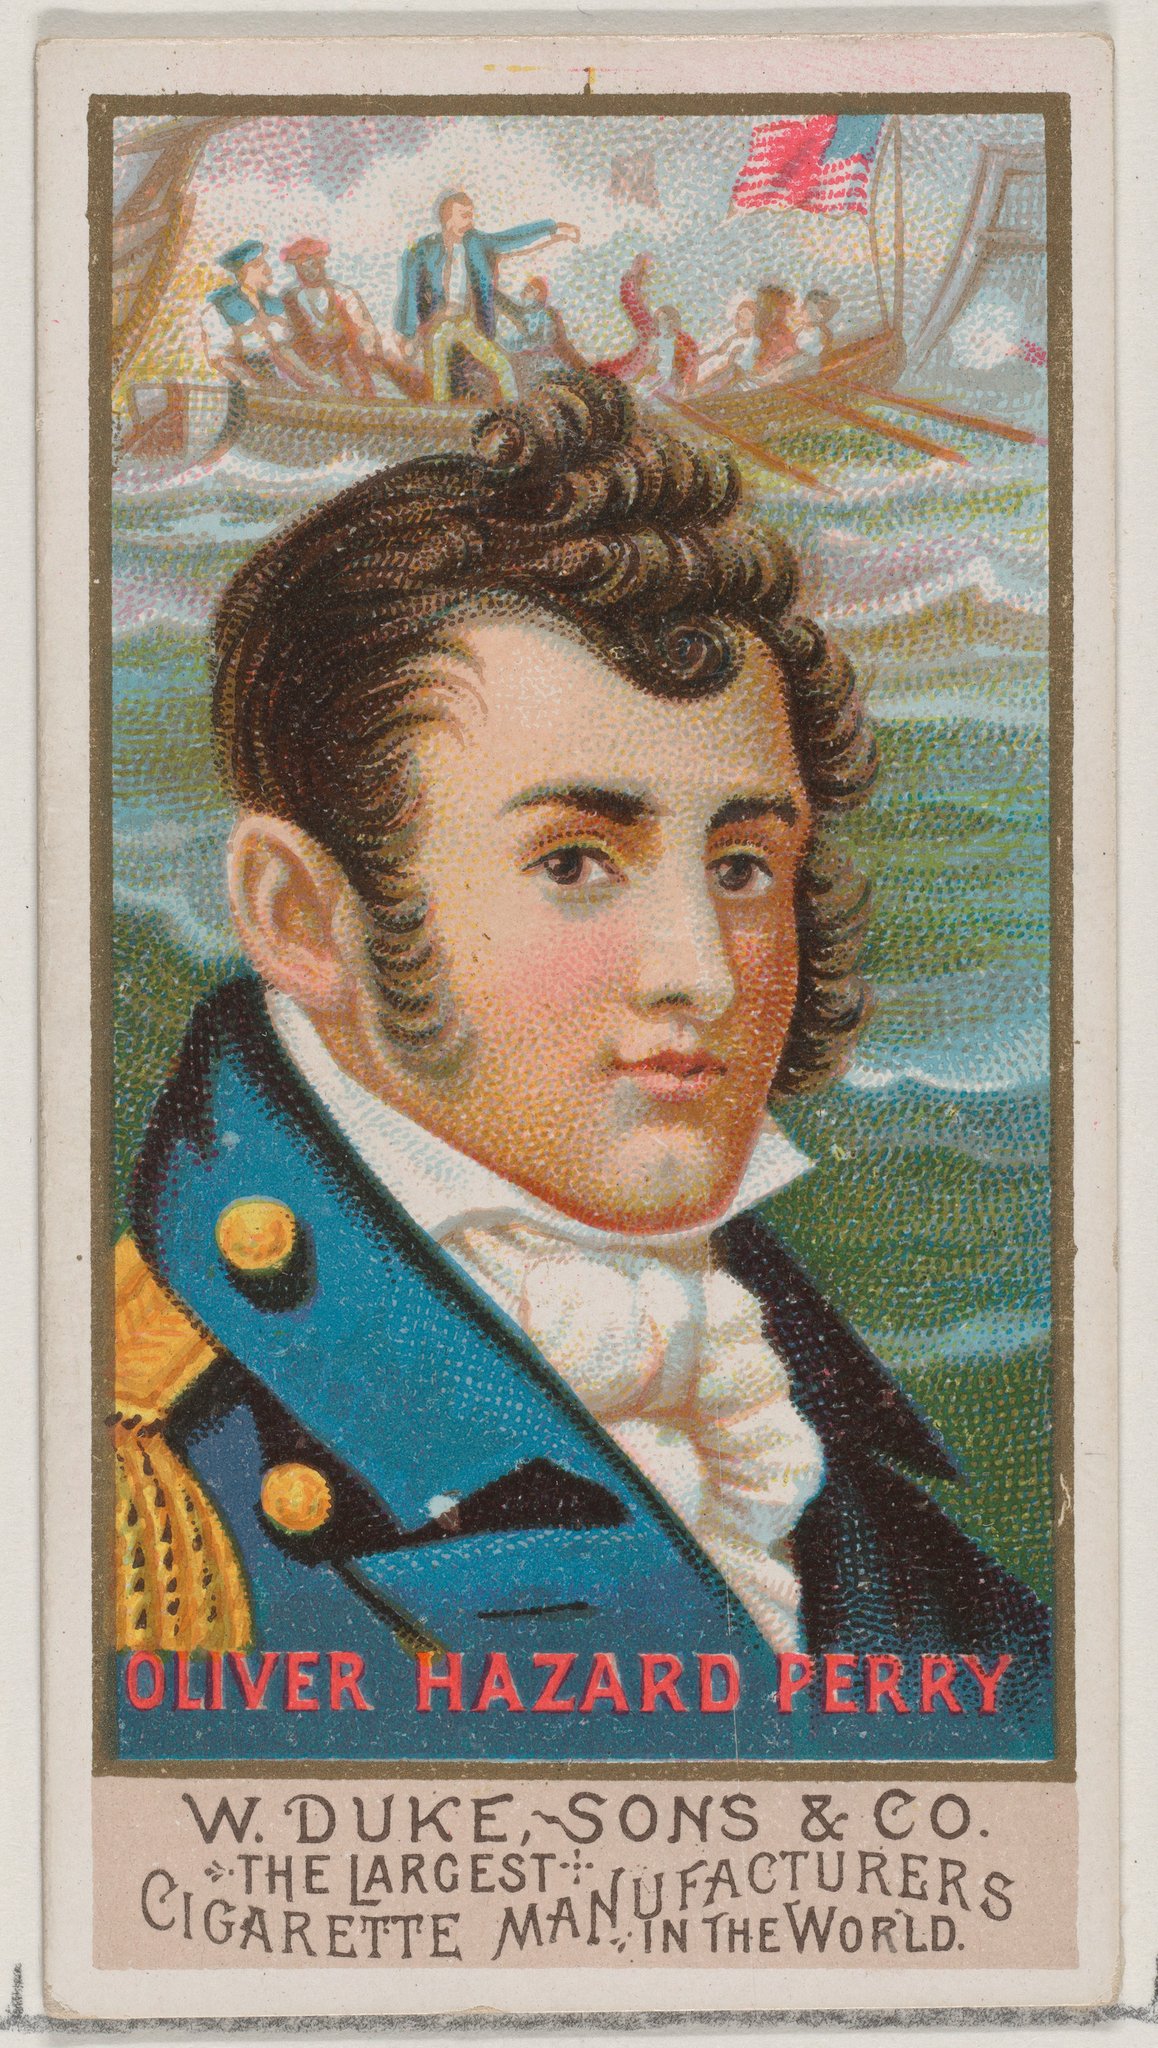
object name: print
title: Oliver Hazard Perry, from the series Great Americans (N76) for Duke brand cigarettes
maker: w. duke, sons & co.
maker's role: publisher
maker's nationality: american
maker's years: 1870-1920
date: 1888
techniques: color lithograph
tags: men